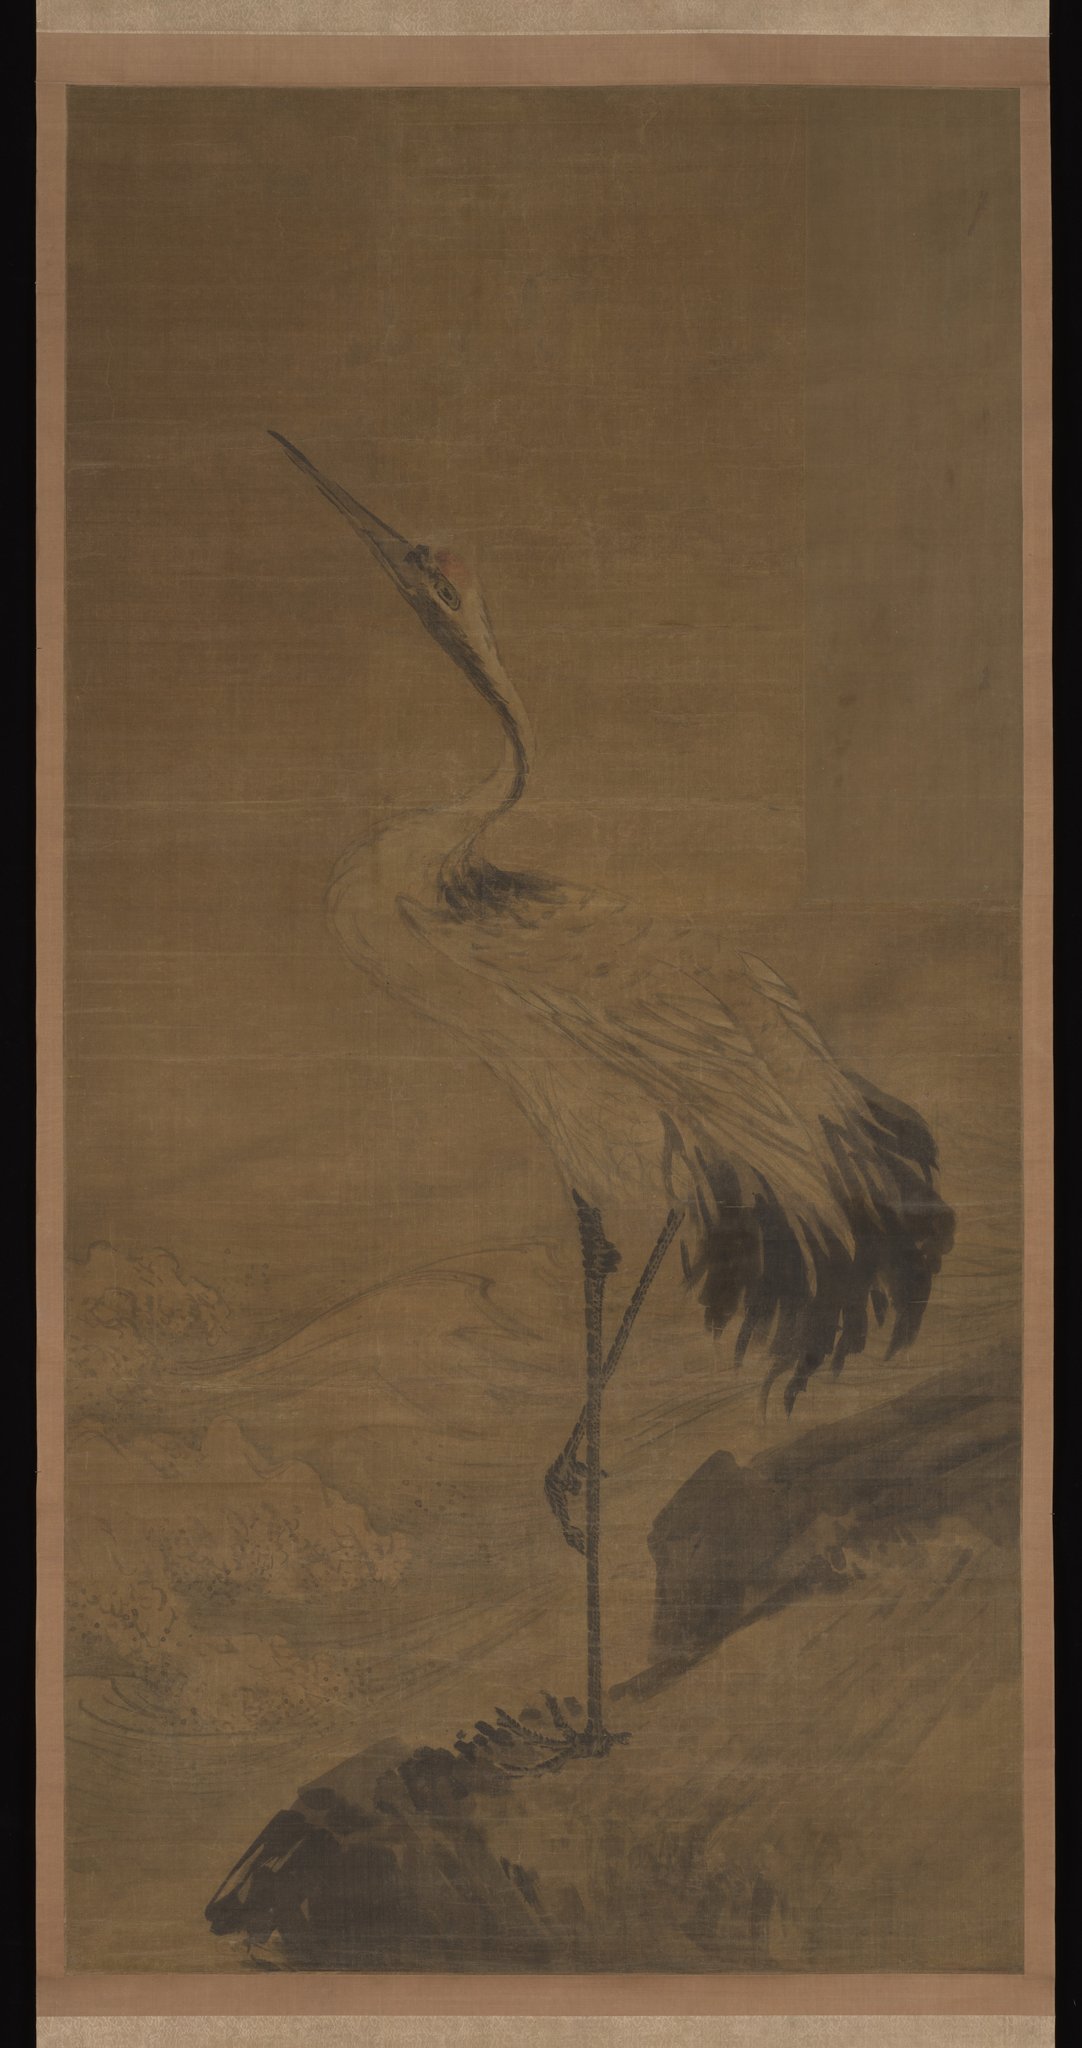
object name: hanging scroll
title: Crane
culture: chinese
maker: unidentified artist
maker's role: artist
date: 1368-1644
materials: ink, silk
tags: cranes